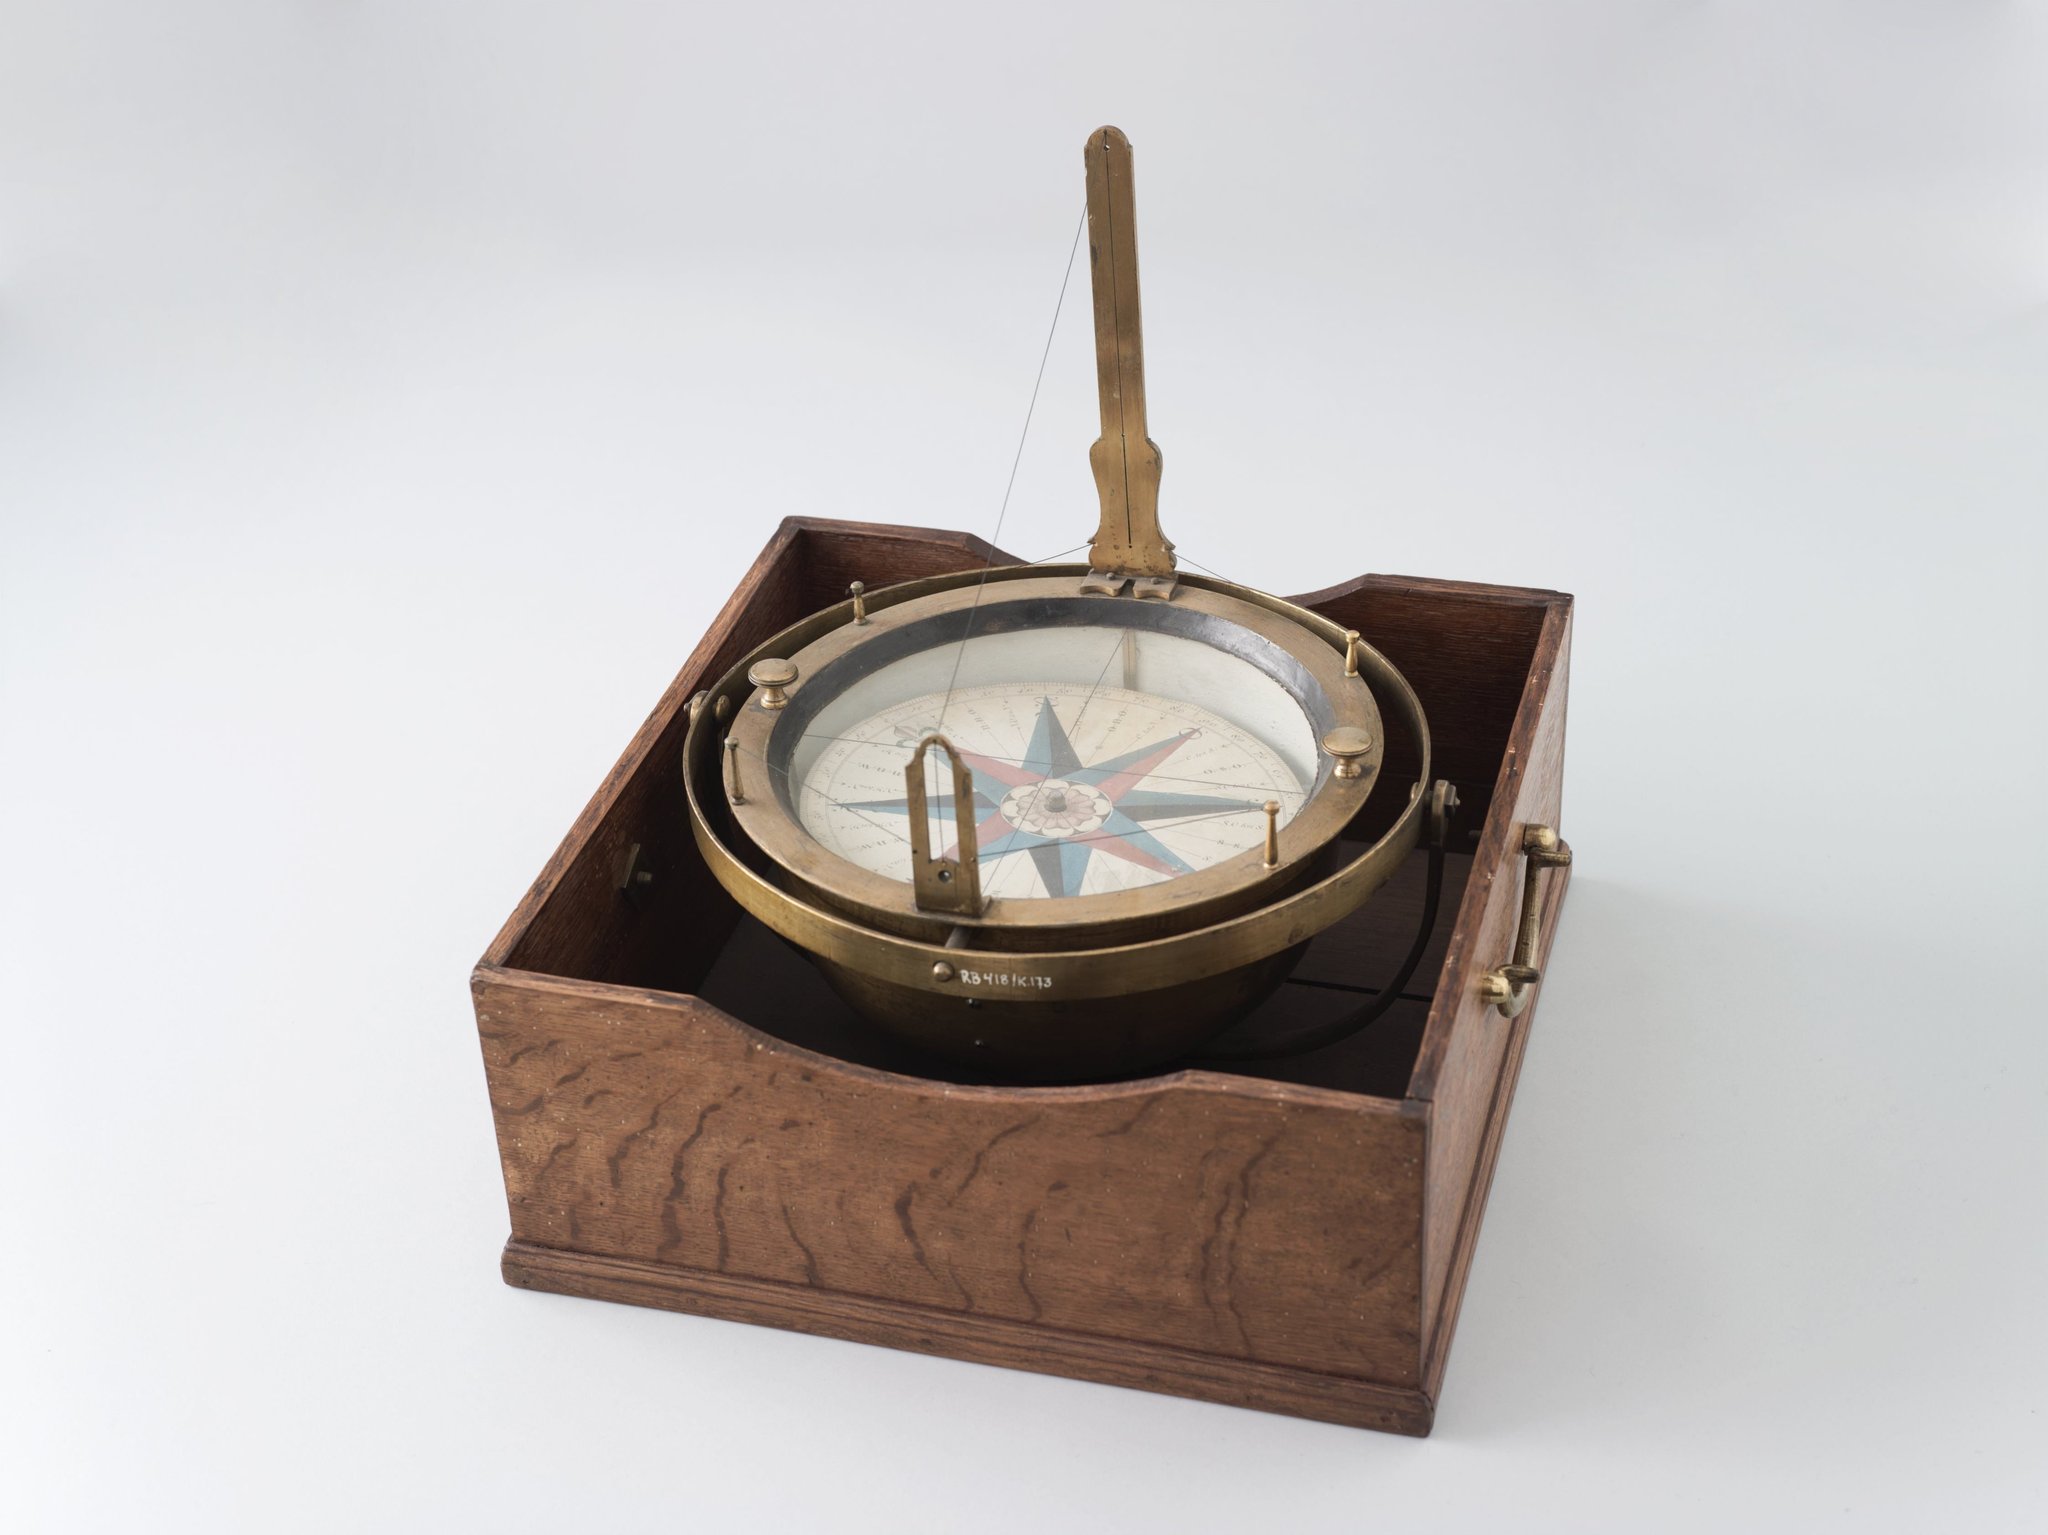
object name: compass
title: Azimuth Compass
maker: johannes van keulen (i)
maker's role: bookseller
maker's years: 1653-1715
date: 1750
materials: brass, glass, iron, lacquer, lead, paper, gemstone, wood, yarns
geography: amsterdam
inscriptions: inscription, on the compass card: ‘"T” AMSTERDAM by IOHANNES VAN KEULEN’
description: Azimutkompas in cardanusring in een houten doos, waarvan de deksel ontbreekt. De cardanusring kan gedraaid worden voor peilingen. Het kompas heeft een vaste pelorus, de ketel is verzwaard met een loden gewicht onderaan. De roos is van mica gemaakt, aan beide zijden beplakt met papier; hij is met de hand ingekleurd en uitgebalanceerd met wat zwarte lak onderop.